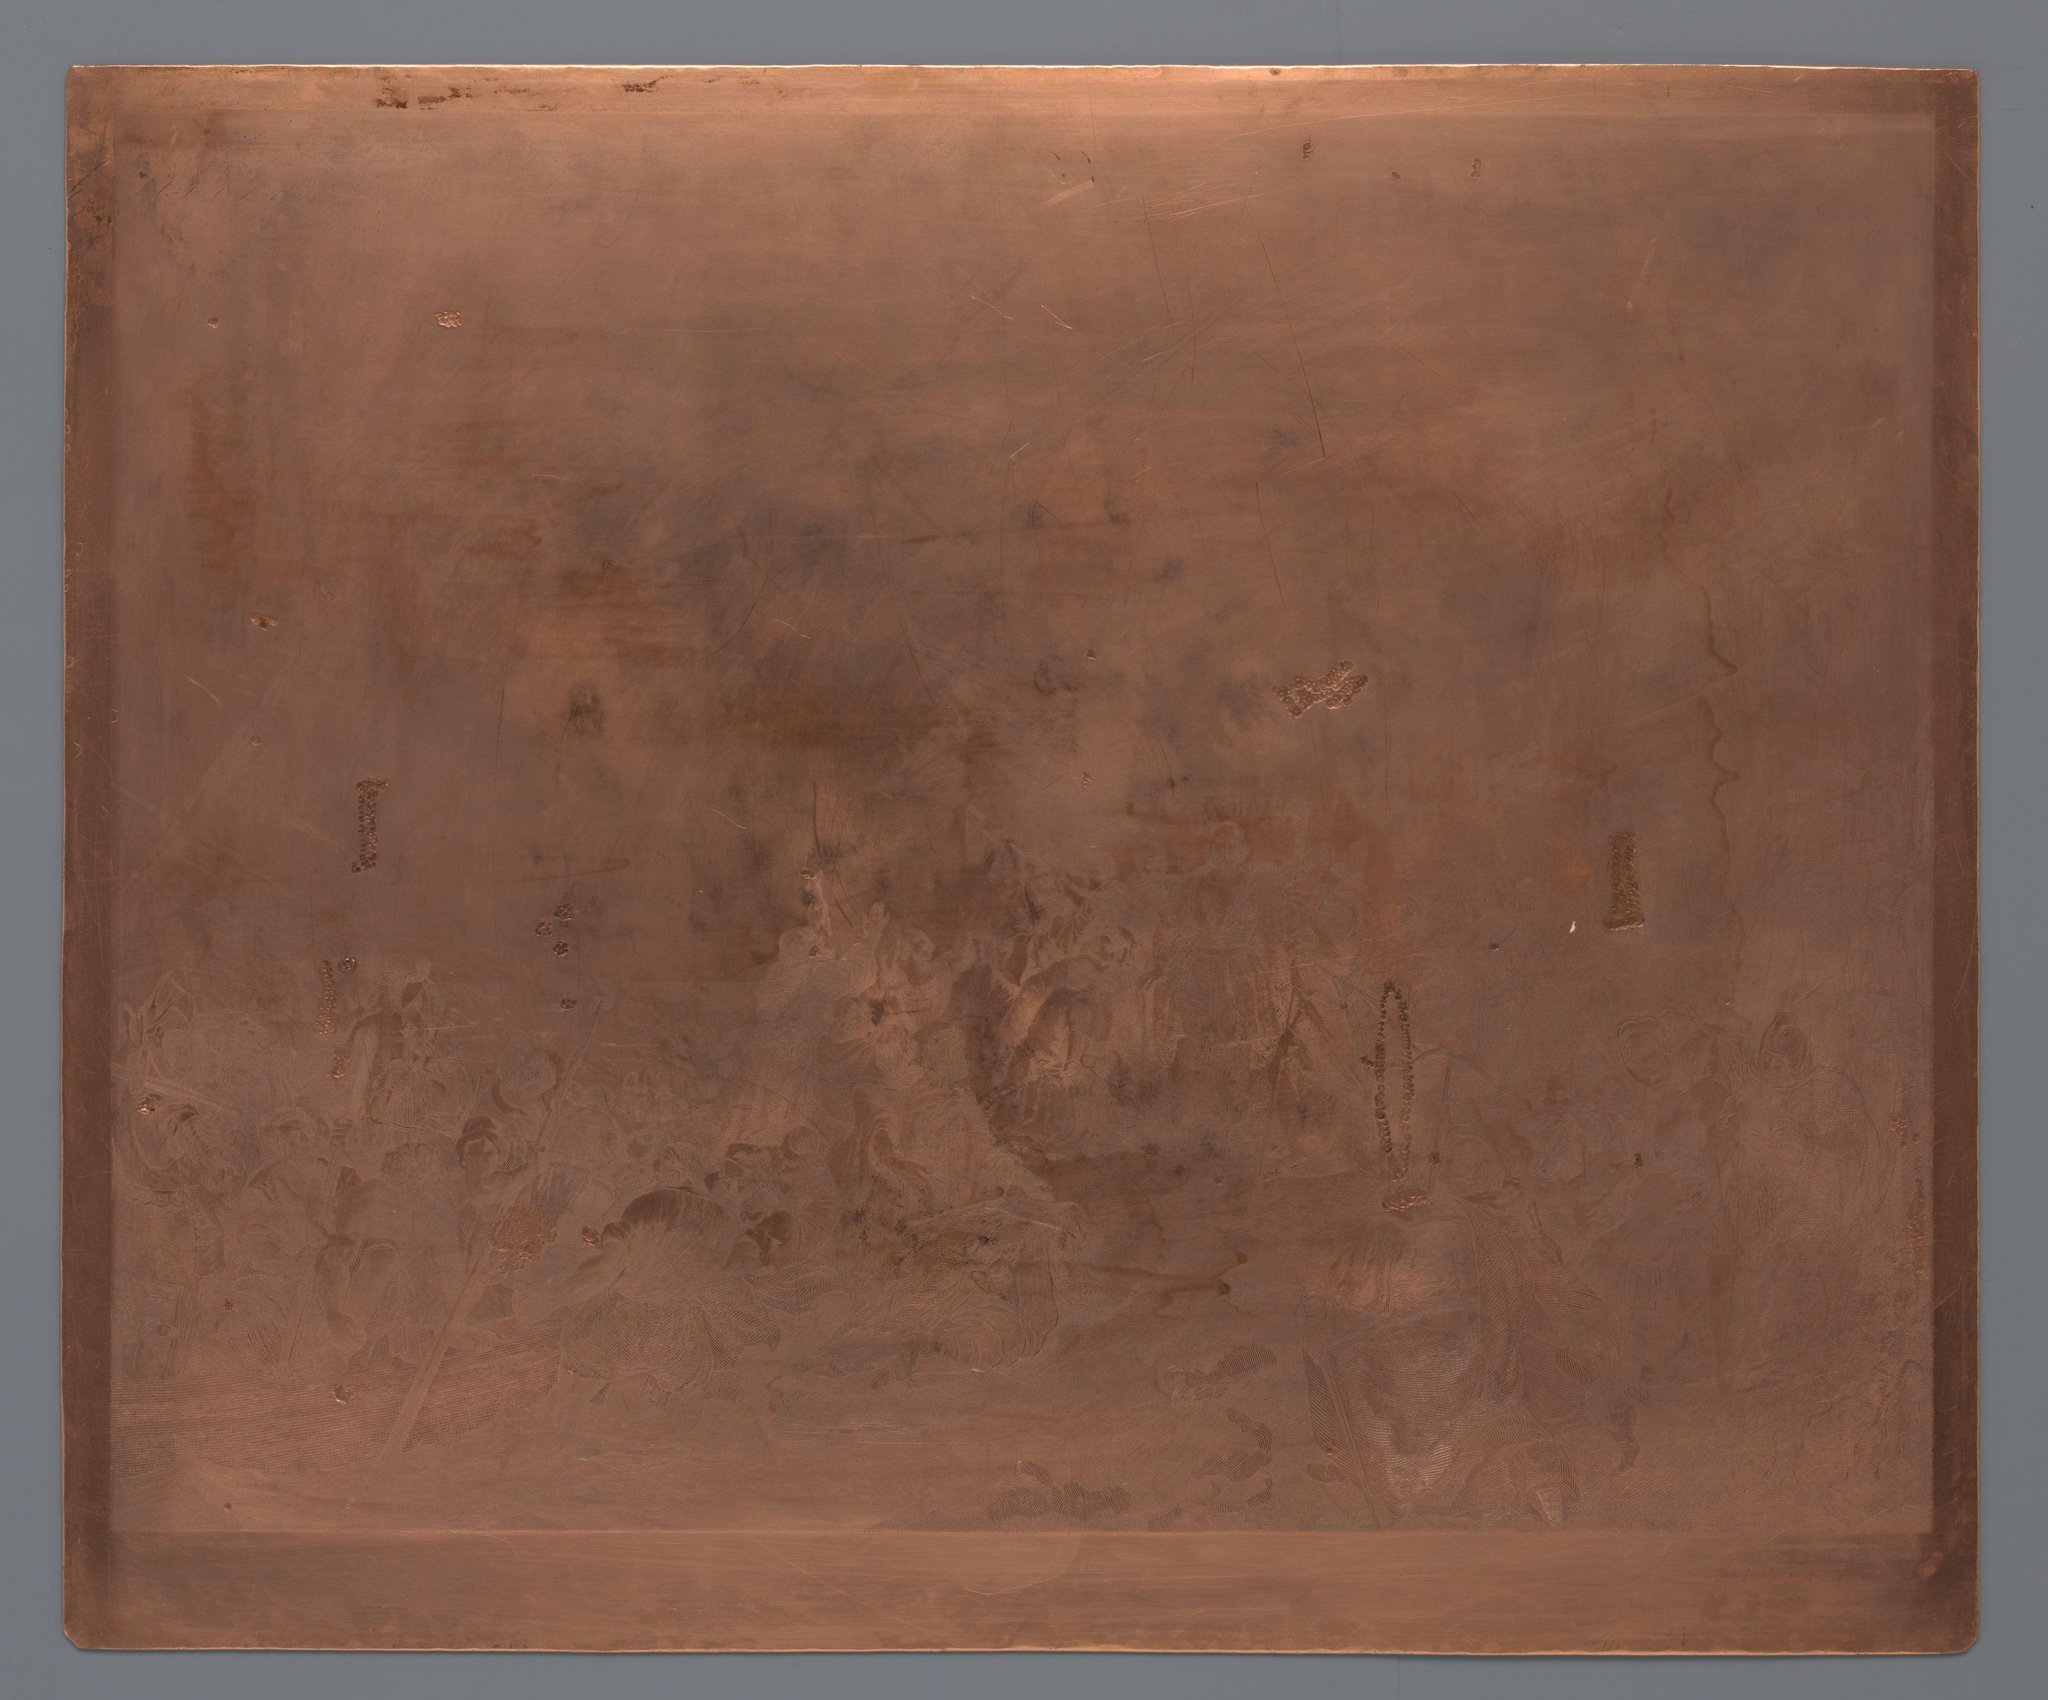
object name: copper plate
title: Tien honden in en voor een hondenhok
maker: dirk jurriaan sluyter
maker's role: draughtsman, print maker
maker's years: 1811-1886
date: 1821-1886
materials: copper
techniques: engraving